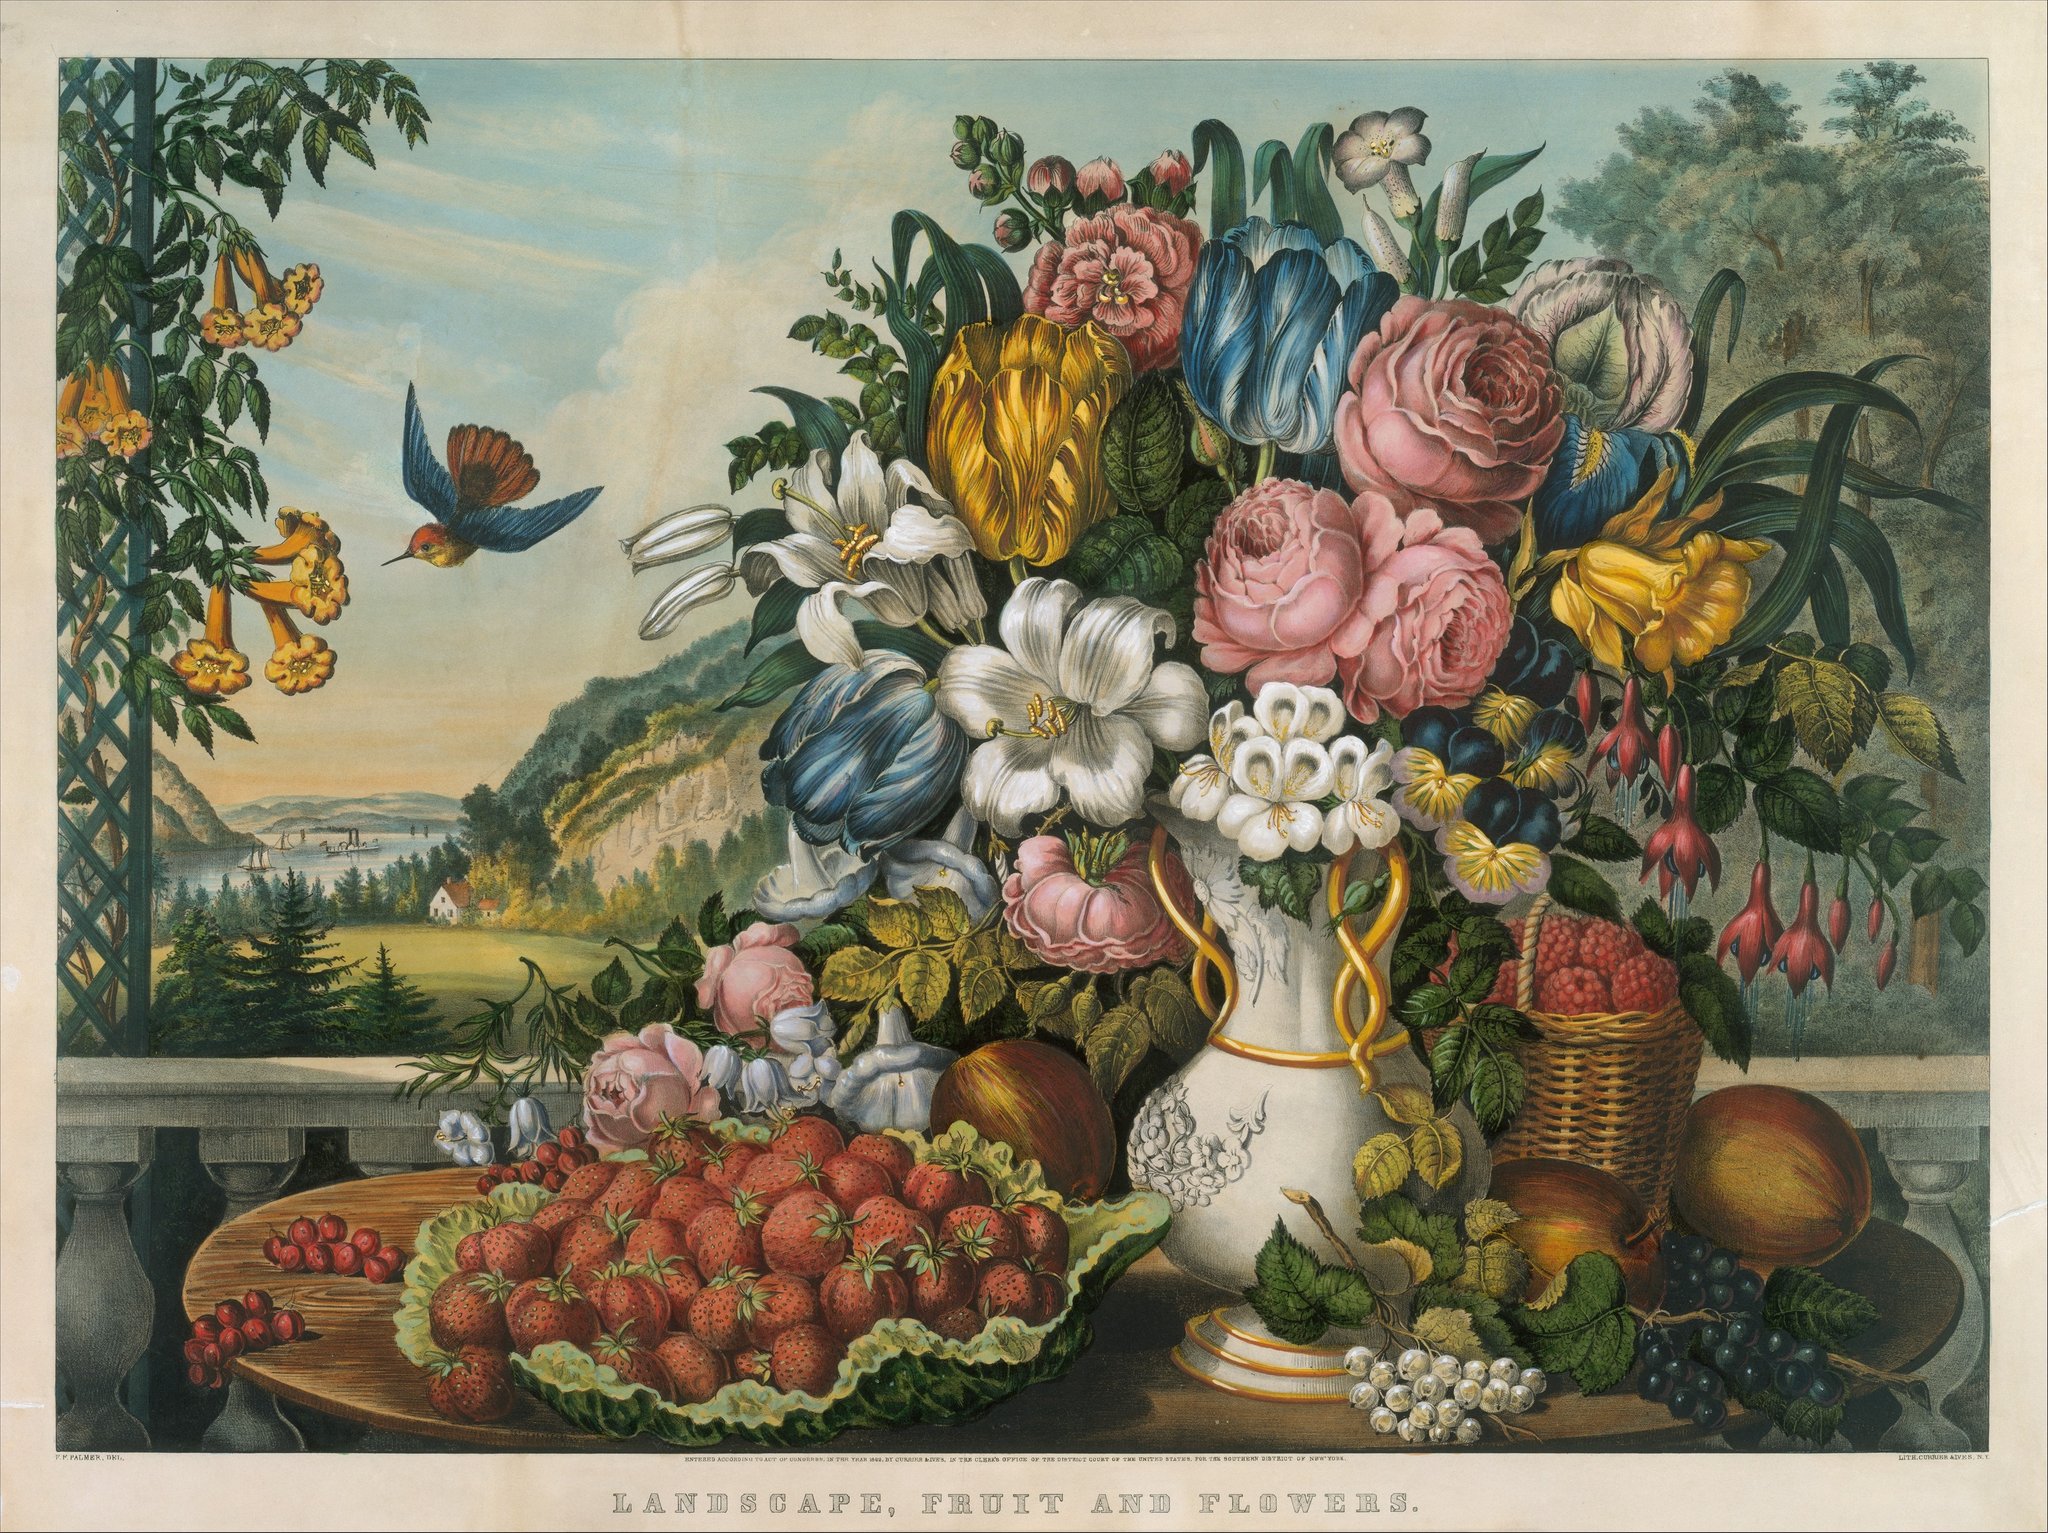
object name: print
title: Landscape – Fruit and Flowers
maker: frances flora bond palmer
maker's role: artist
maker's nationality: american, born england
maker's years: 1812-1876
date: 1862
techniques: hand coloring, lithograph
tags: birds,fruit,grapes,strawberries,flowers